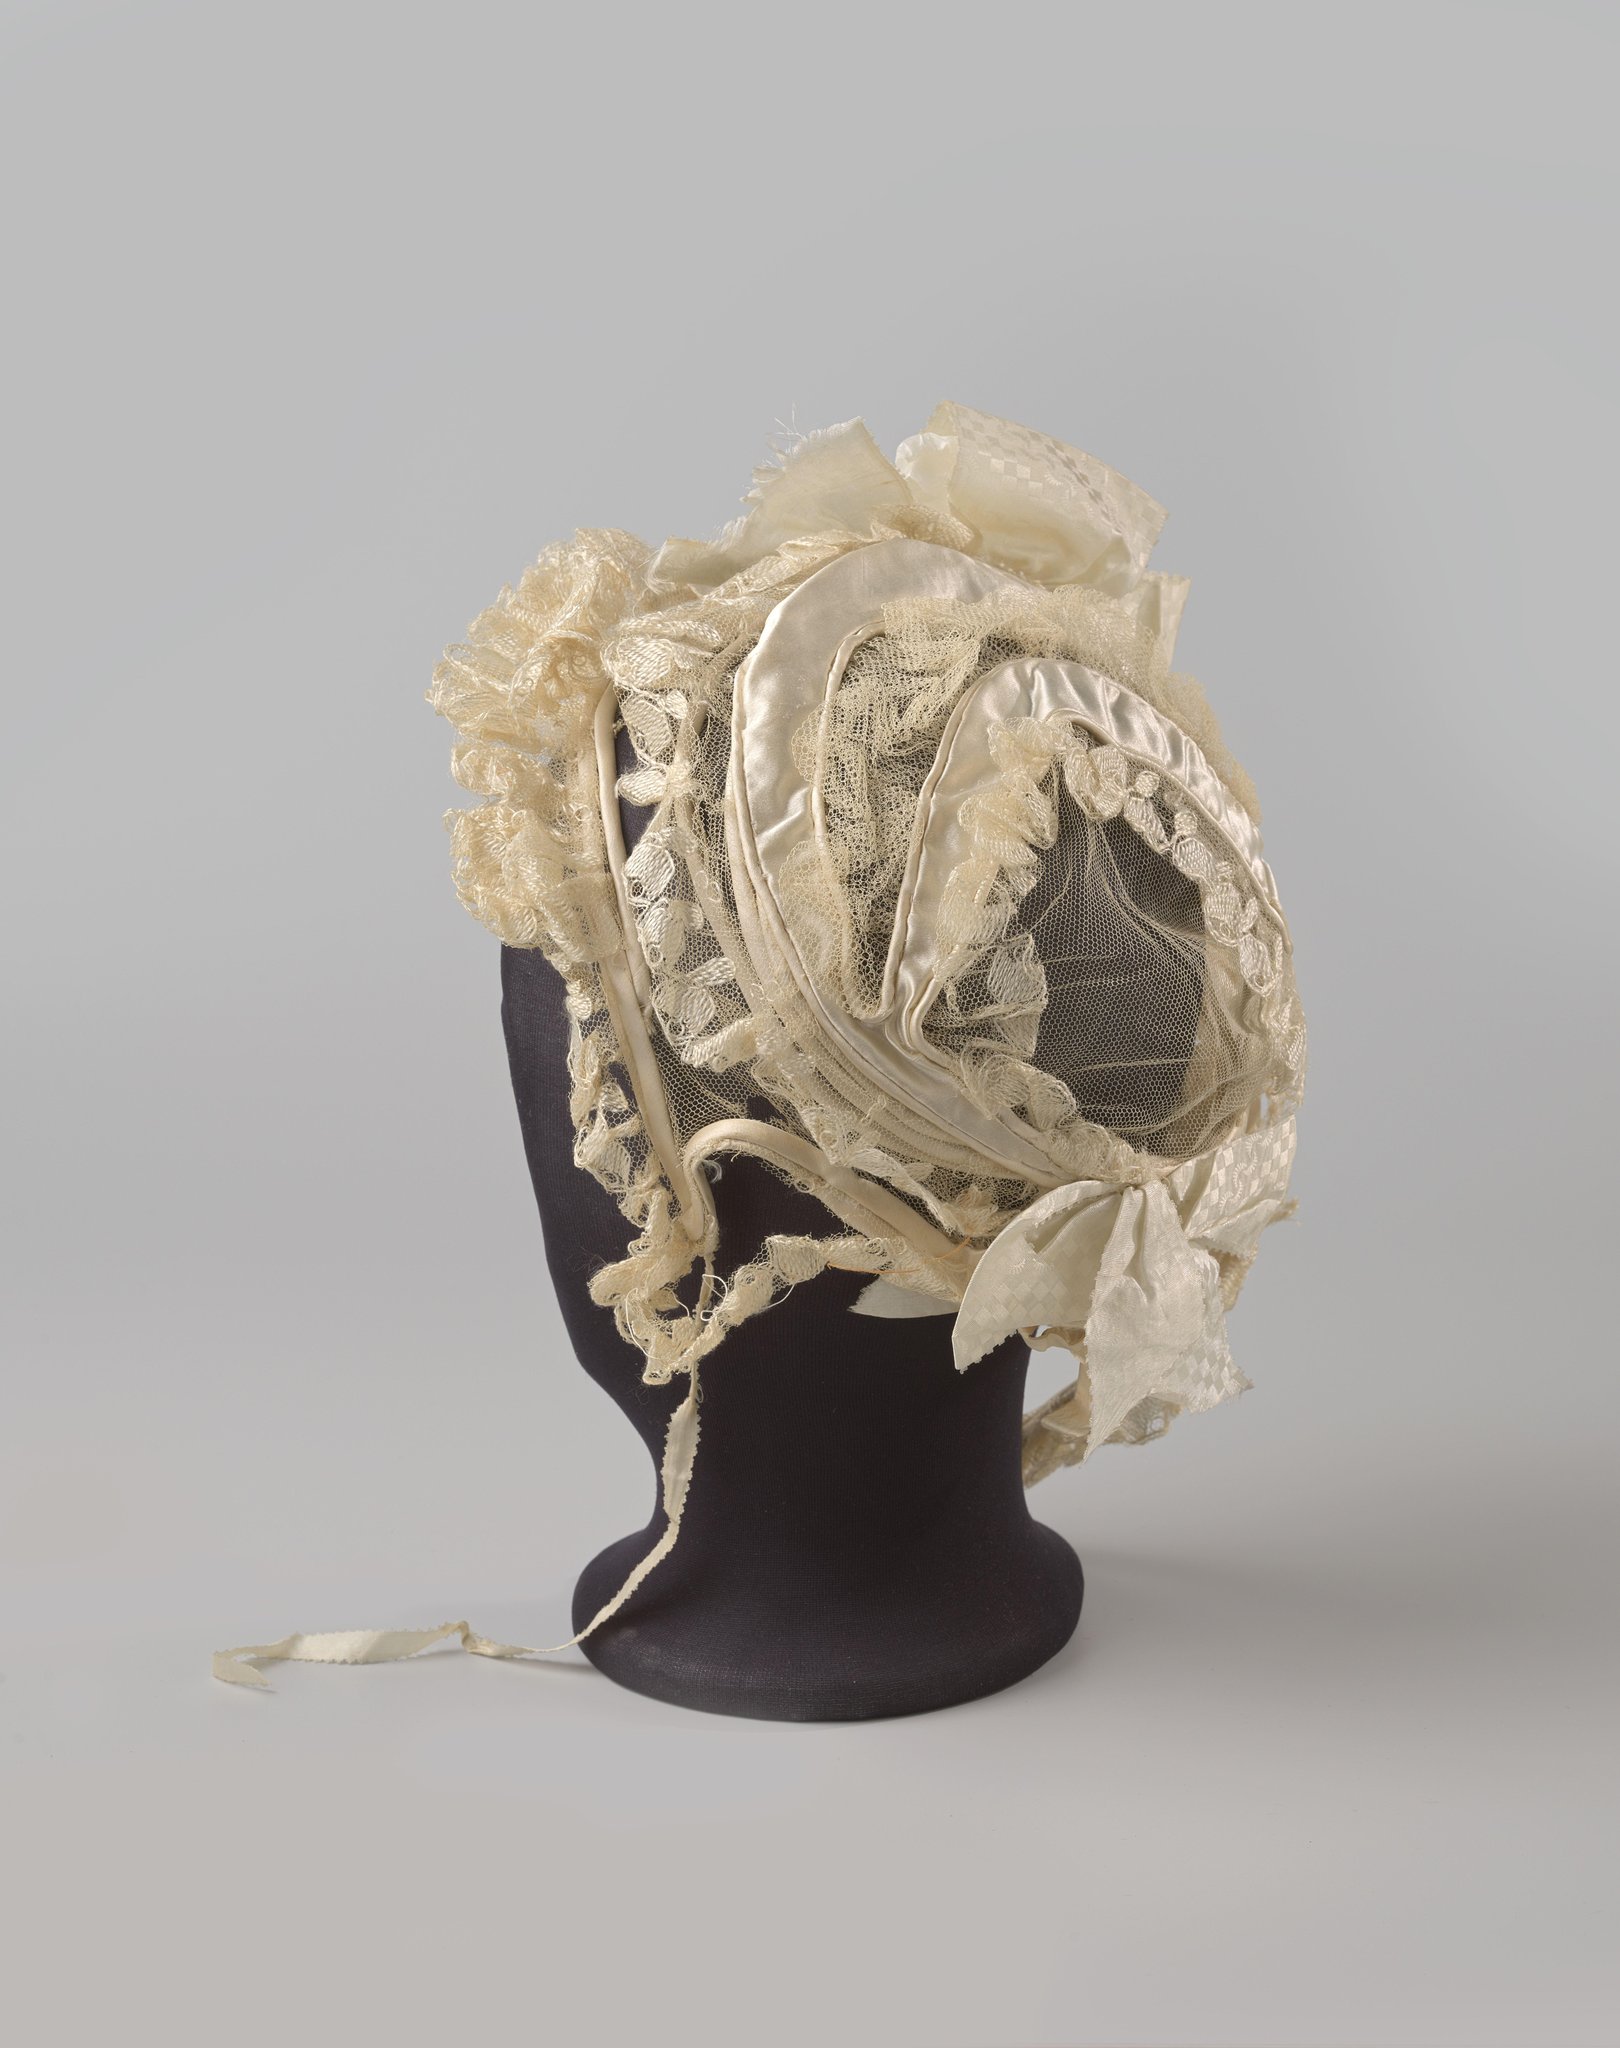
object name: womenswear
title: Hoed van tule en wit satijn, versierd met tule-doorstop en lint; model met ronde bol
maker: Anonymous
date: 1905-1920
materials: textile, silk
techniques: stopwork, rib binding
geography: france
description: Dameshoedje van tulle, wit satijn, tulle-doorstop en lint. Laat-Empire: Model: ronde opgedofte bol van tulle met twee sikkelvormige incrustaties van satijn met biesjes die met koord gevuld zijn. Een glad voorhoofdgedeelte zet zich opzij puntig, als een oorijzermuts, naar voren voort. Drie kantstroken zijn langs de sikkelmotieven en vòòrlangs genaaid. Versiering. kantstroken zijn van zijden tulle met glimmend witte floszijde doorgestopt. Het patroon bestaat uit stijve klokjes bloemen die in halfronde schulpen hangen. Licht patroon. Witte ripszijde vertoont een damastpatroon van schuine banen darmbordblokjes en een dubbel slingertje. Toestand: De punten die tegen de wang rusten, zijn sleets, zowel in de tulle als de doorgestopte stroken.